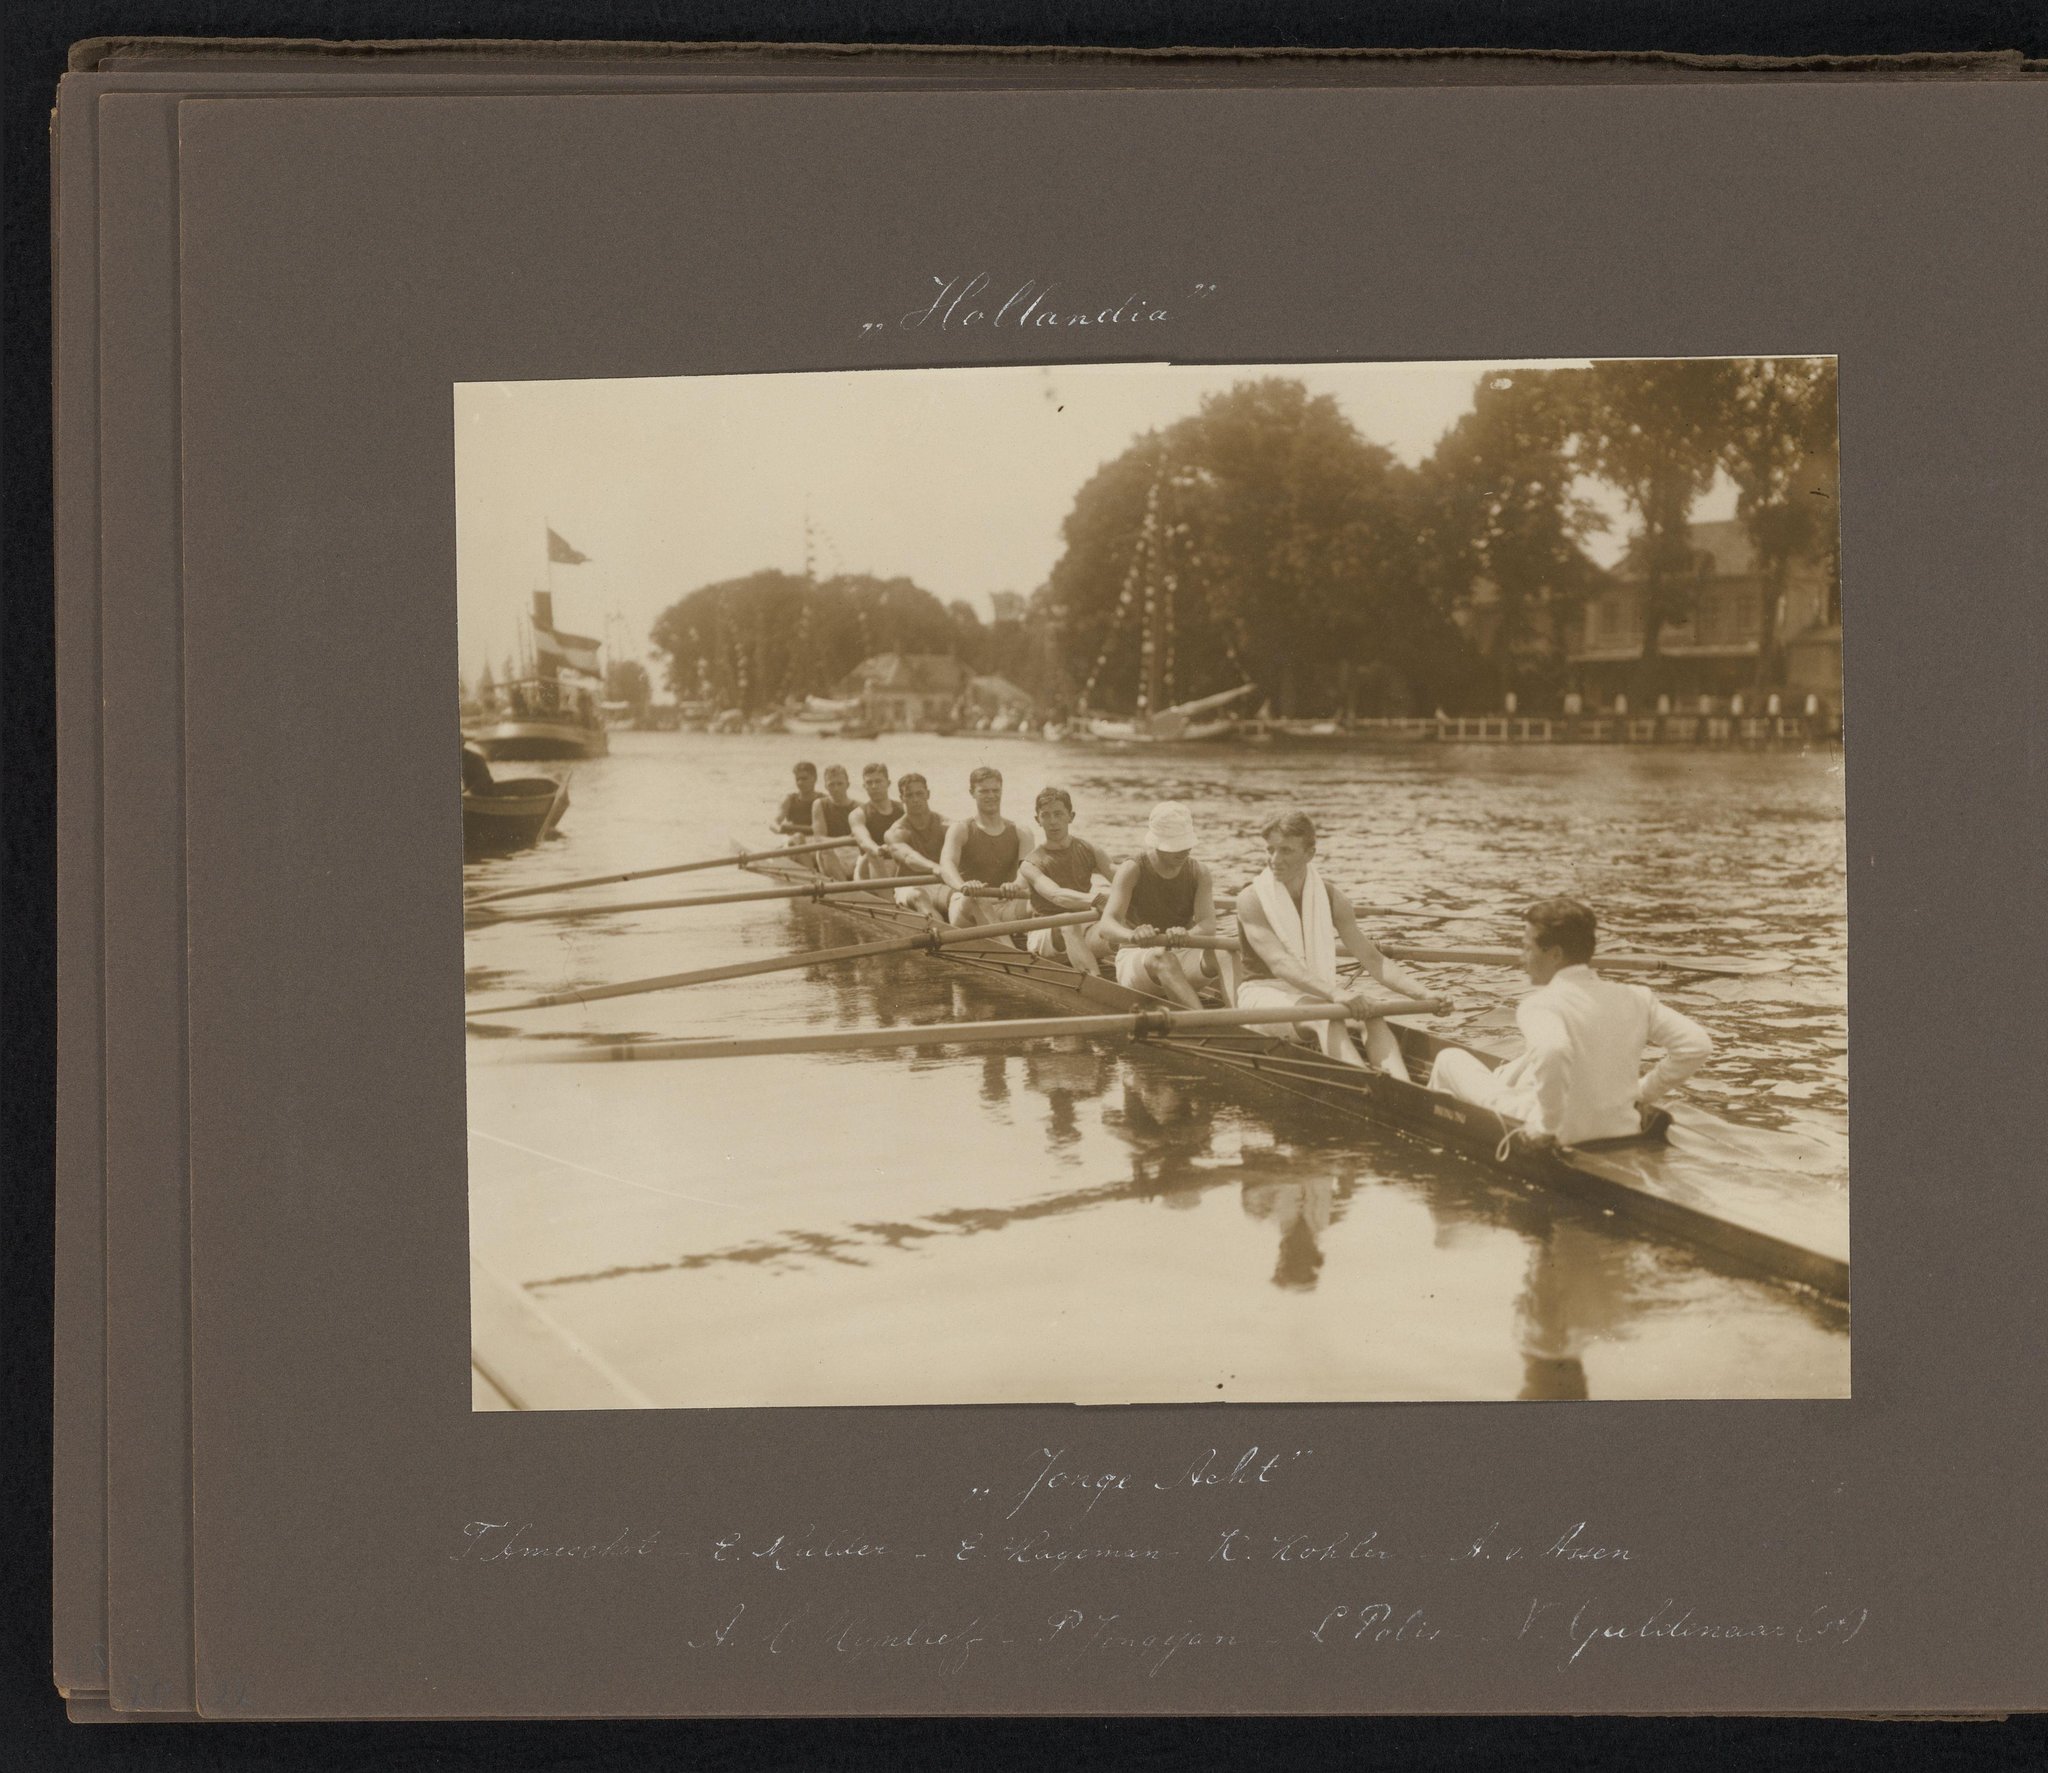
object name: album leaf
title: Jonge Acht in actie op de Amstel, versierde boten op de achtergrond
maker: Anonymous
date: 1906-1915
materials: paper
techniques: gelatin silver print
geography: amsterdam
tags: rowing facing backward, pulling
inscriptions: caption: ‘"Hollandia"/ "Jonge Acht"/’